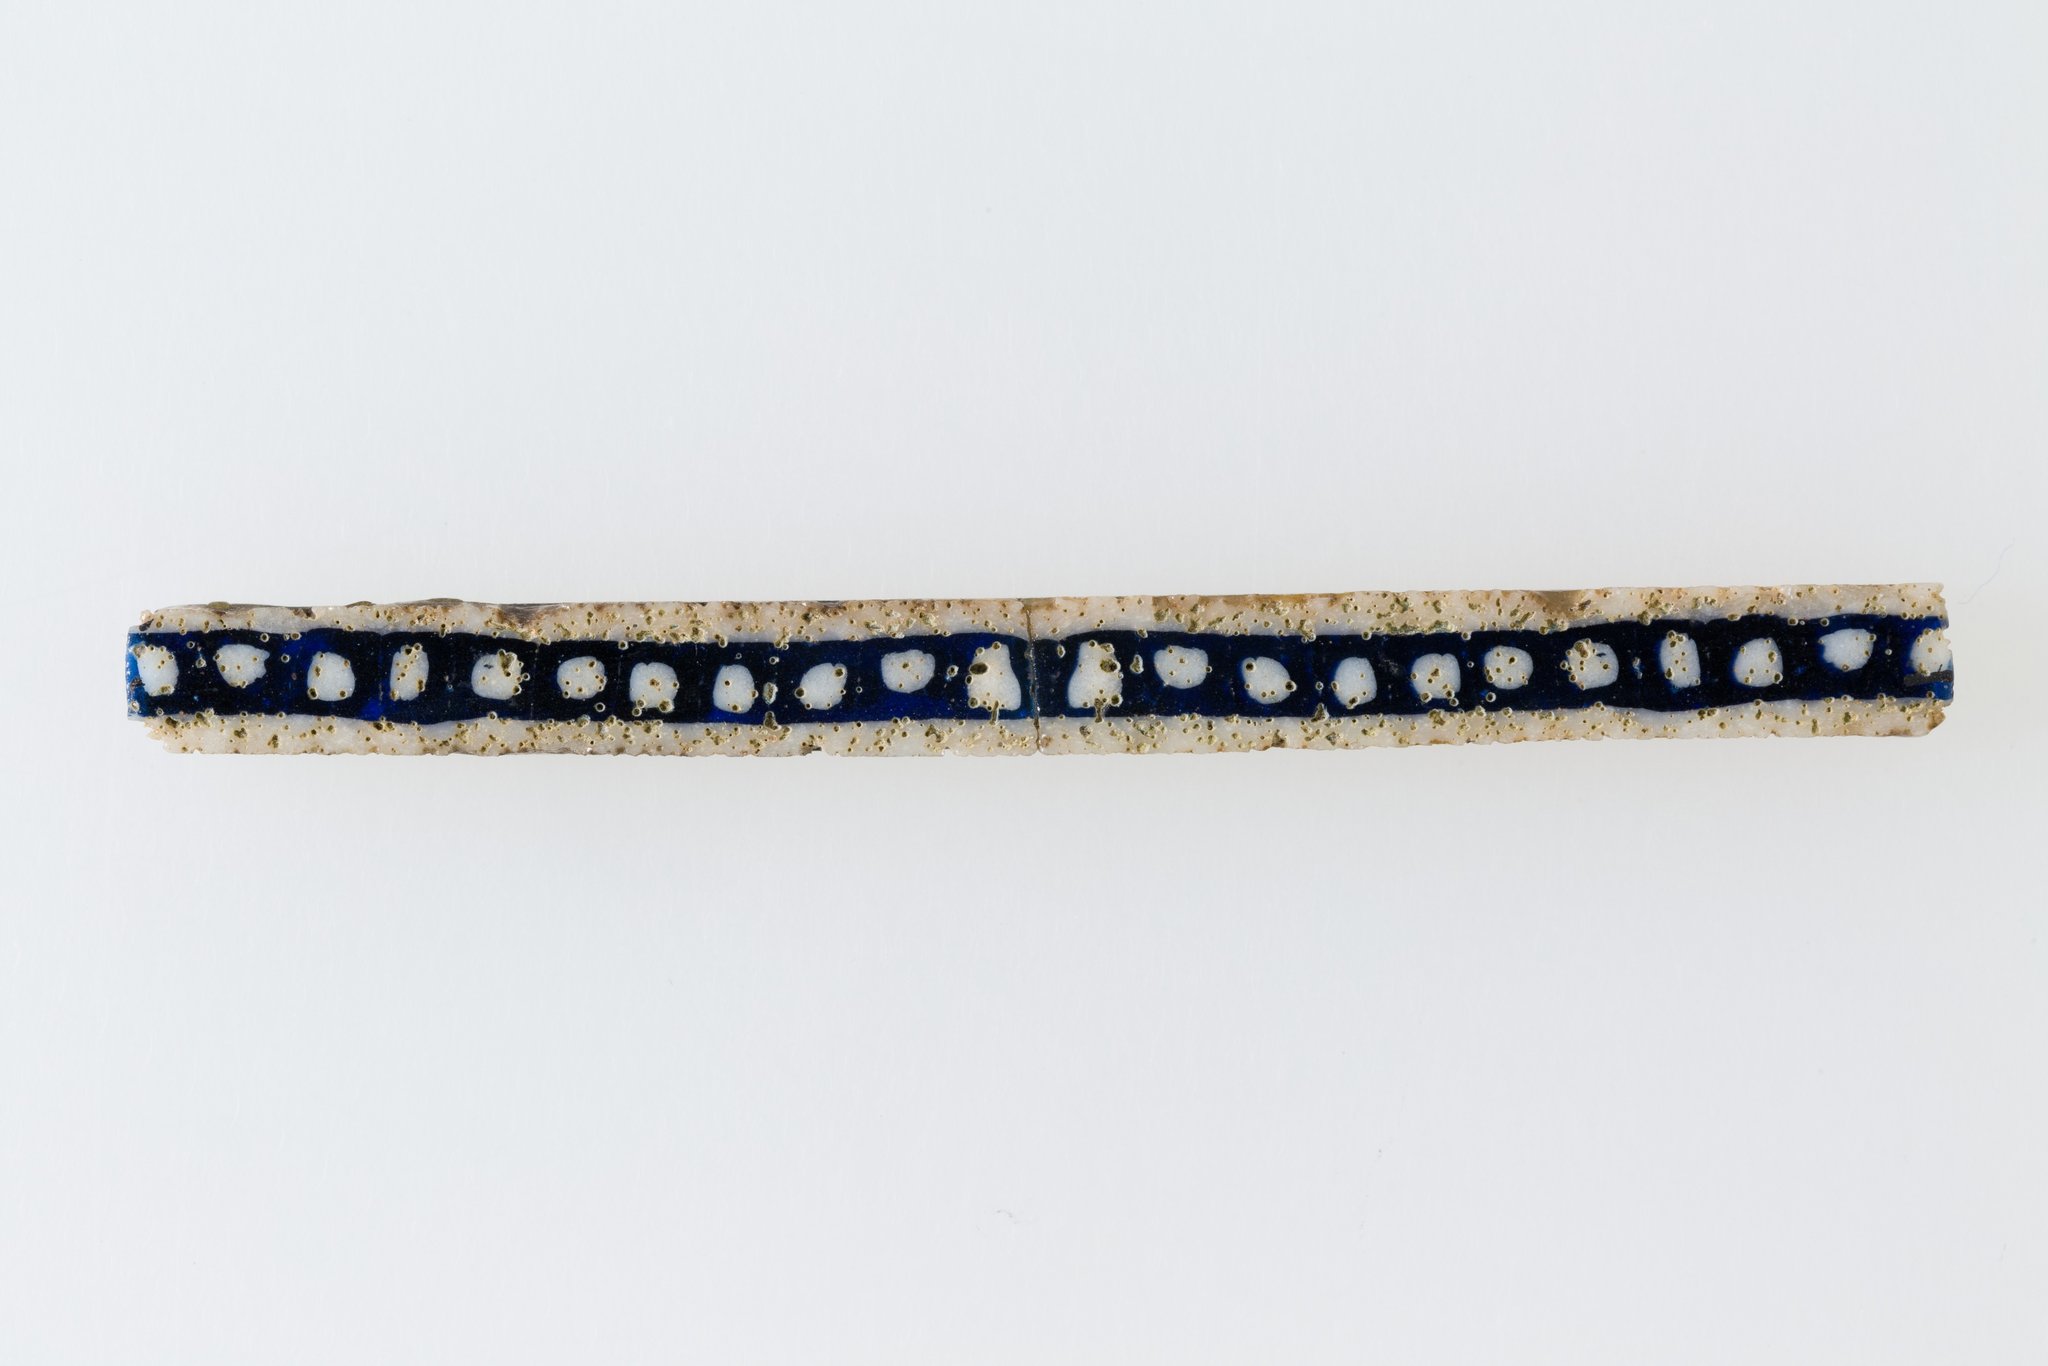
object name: inlay, rosette row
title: Inlay, rosette strip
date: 200 BCE-100 CE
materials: glass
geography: egypt